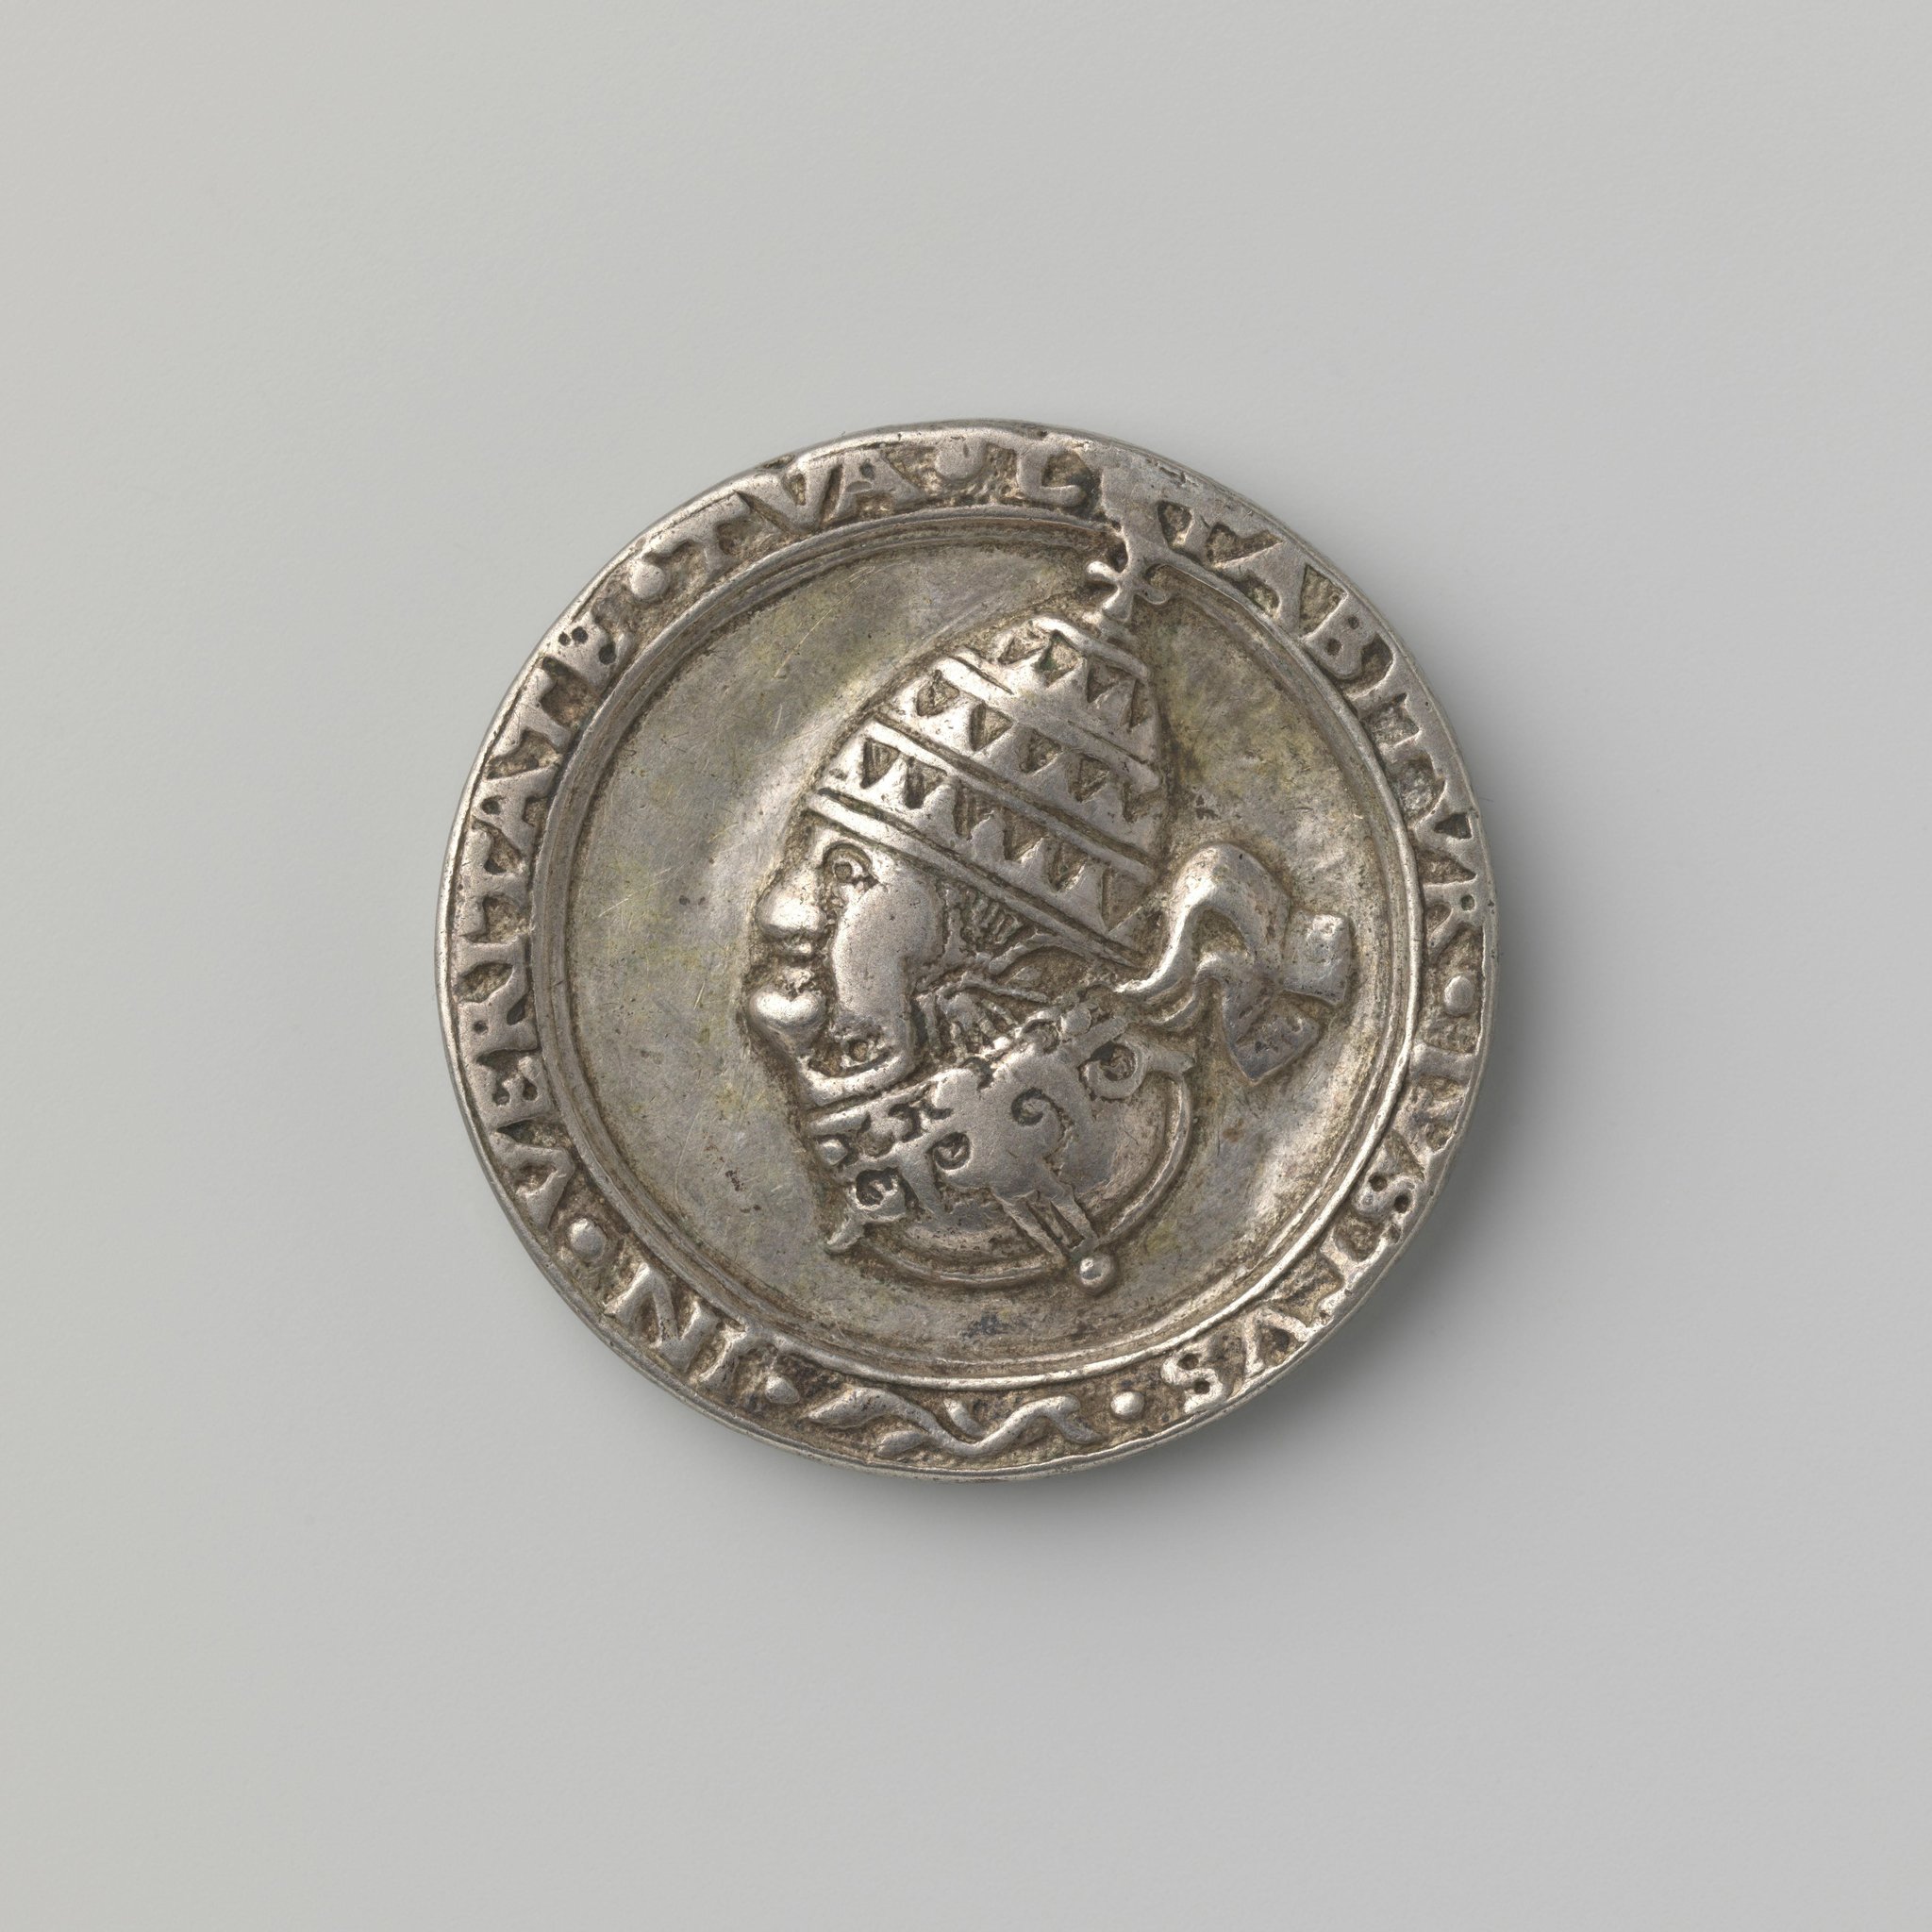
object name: medal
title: Concilie van Trente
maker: Anonymous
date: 1545-1563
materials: silver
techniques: casting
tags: concilie van trente